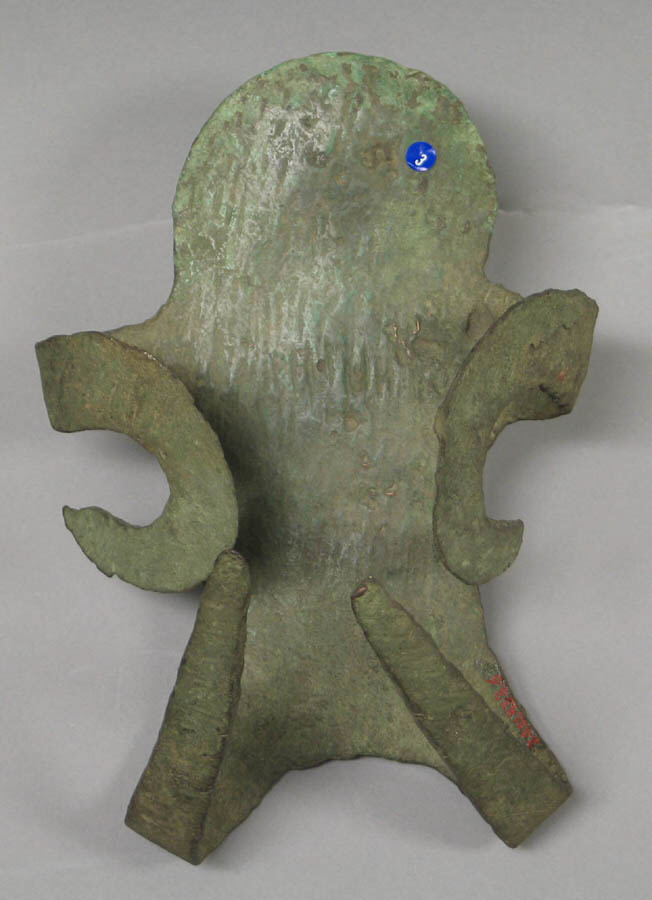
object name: anthropomorph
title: Anthropomorph with Bent Limbs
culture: indian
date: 1500-500 BCE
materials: copper